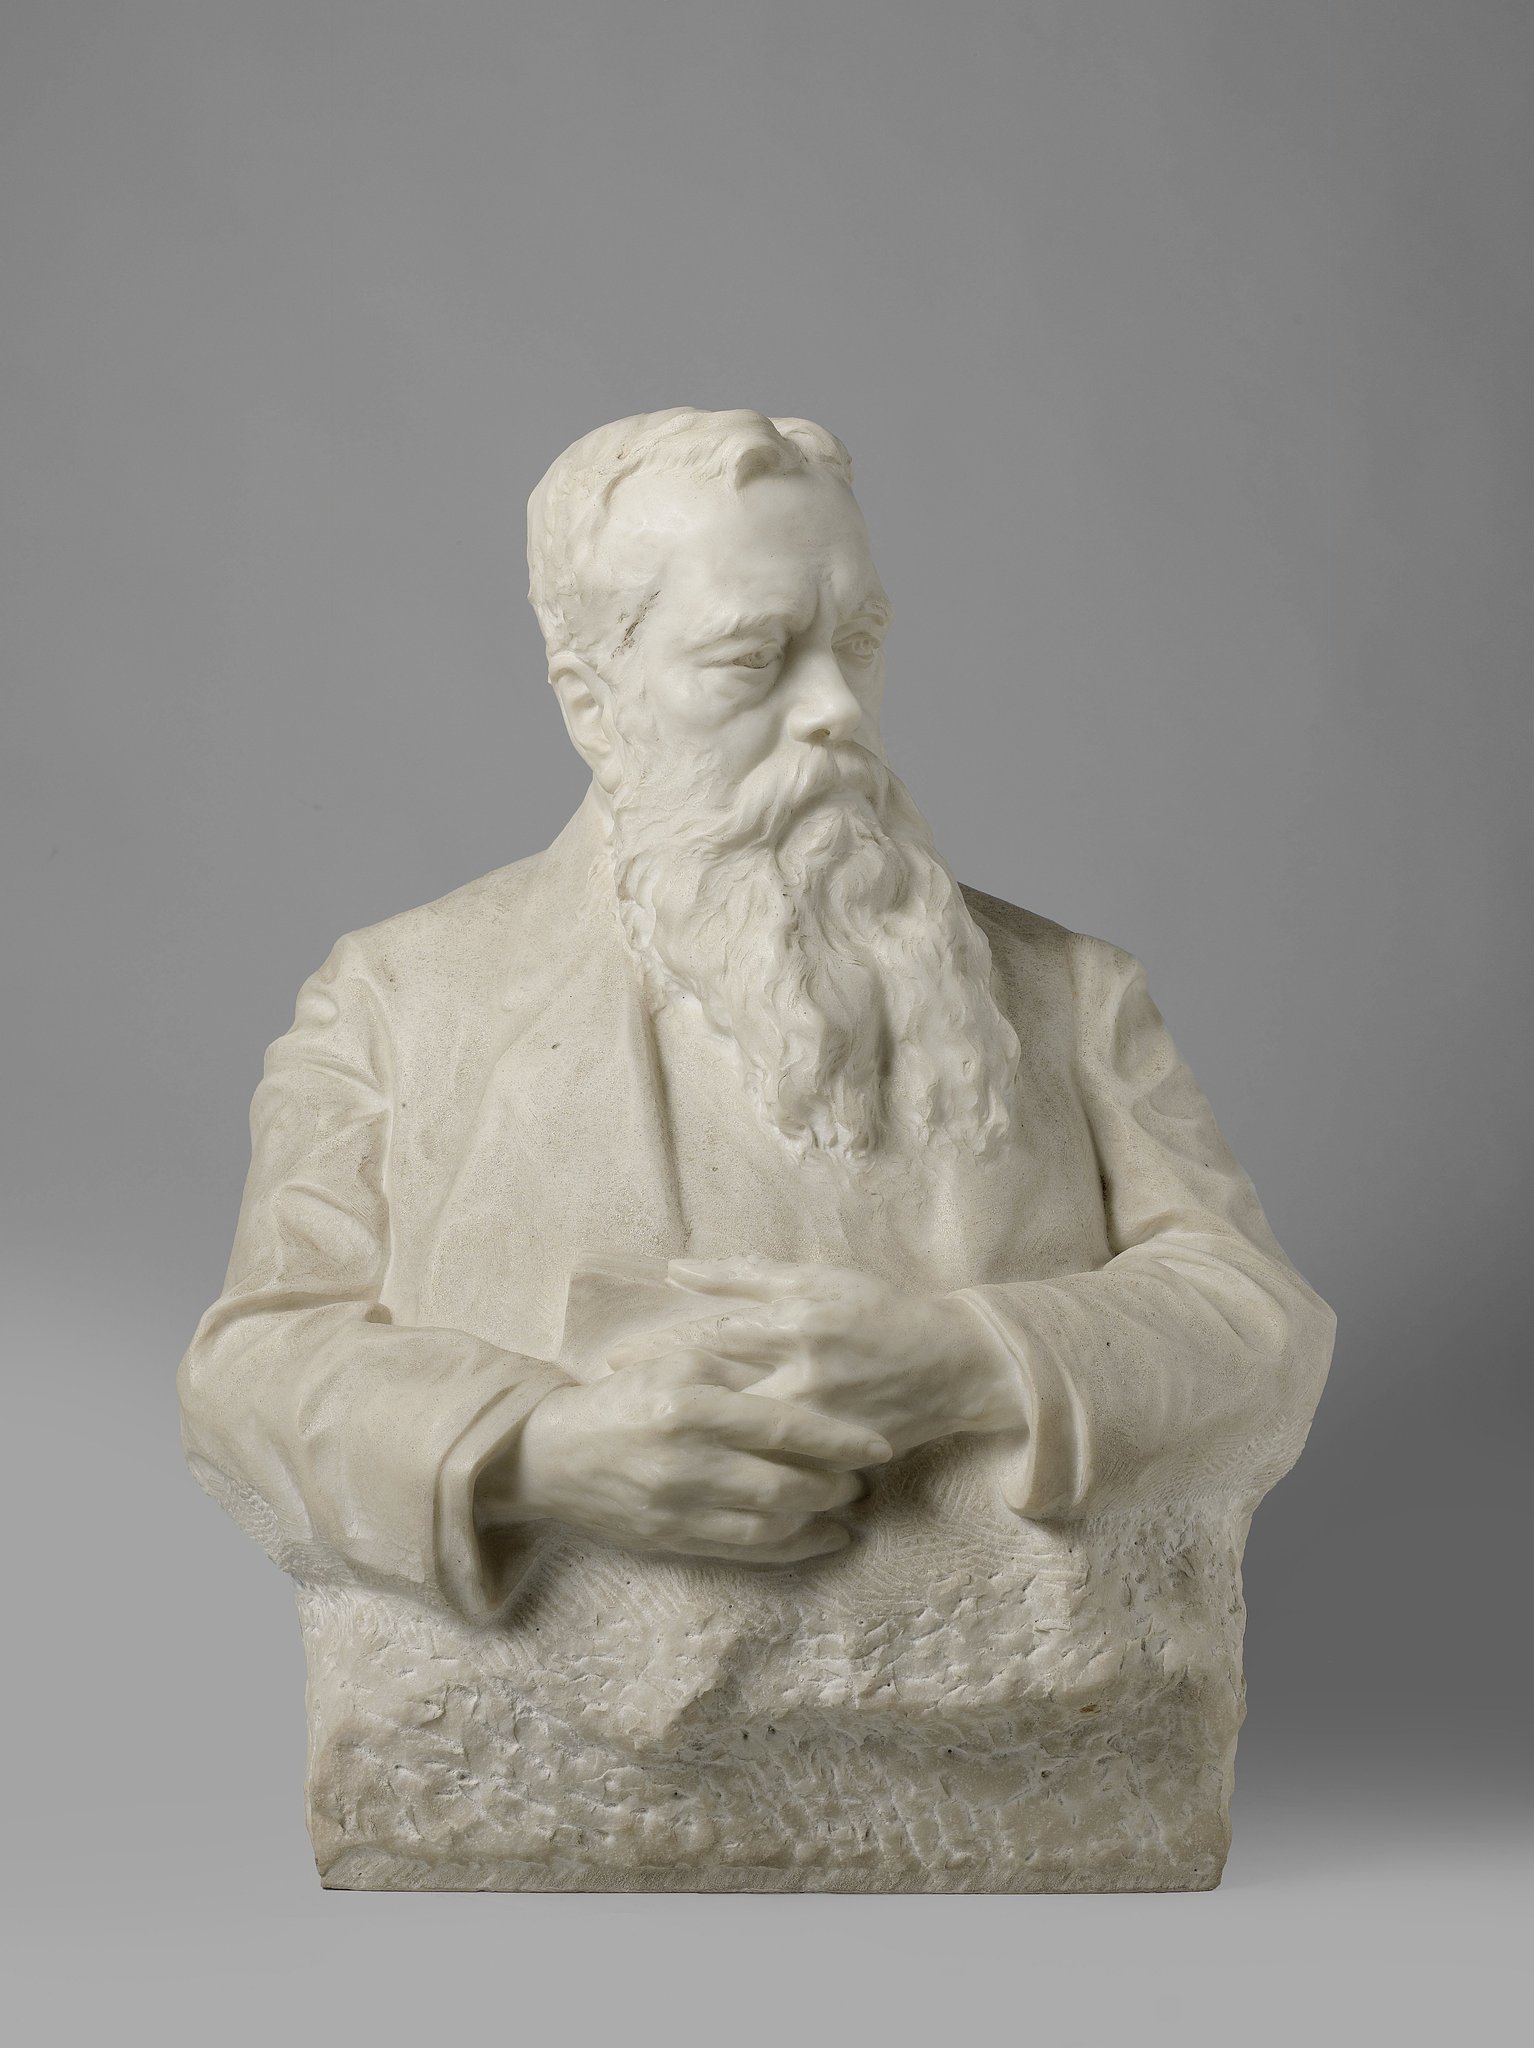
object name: bust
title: Buste van Jhr. Mr. Victor Eugene Louis de Stuers (1843-1916) met sokkel van zwart graniet met grijs mica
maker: toon dupuis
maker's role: sculptor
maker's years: 1877-1937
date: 1914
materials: marble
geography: the hague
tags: jonkheer victor eugène louis de stuers, historical persons (+ (full) bust portrait)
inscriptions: signature and date: ‘Toon Dupuis 1914’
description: Buste van marmer van Jhr. Mr. Victor Eugene Louis de Stuers (1843-1916) met zwart granieten sokkel bestaande uit twee delen.